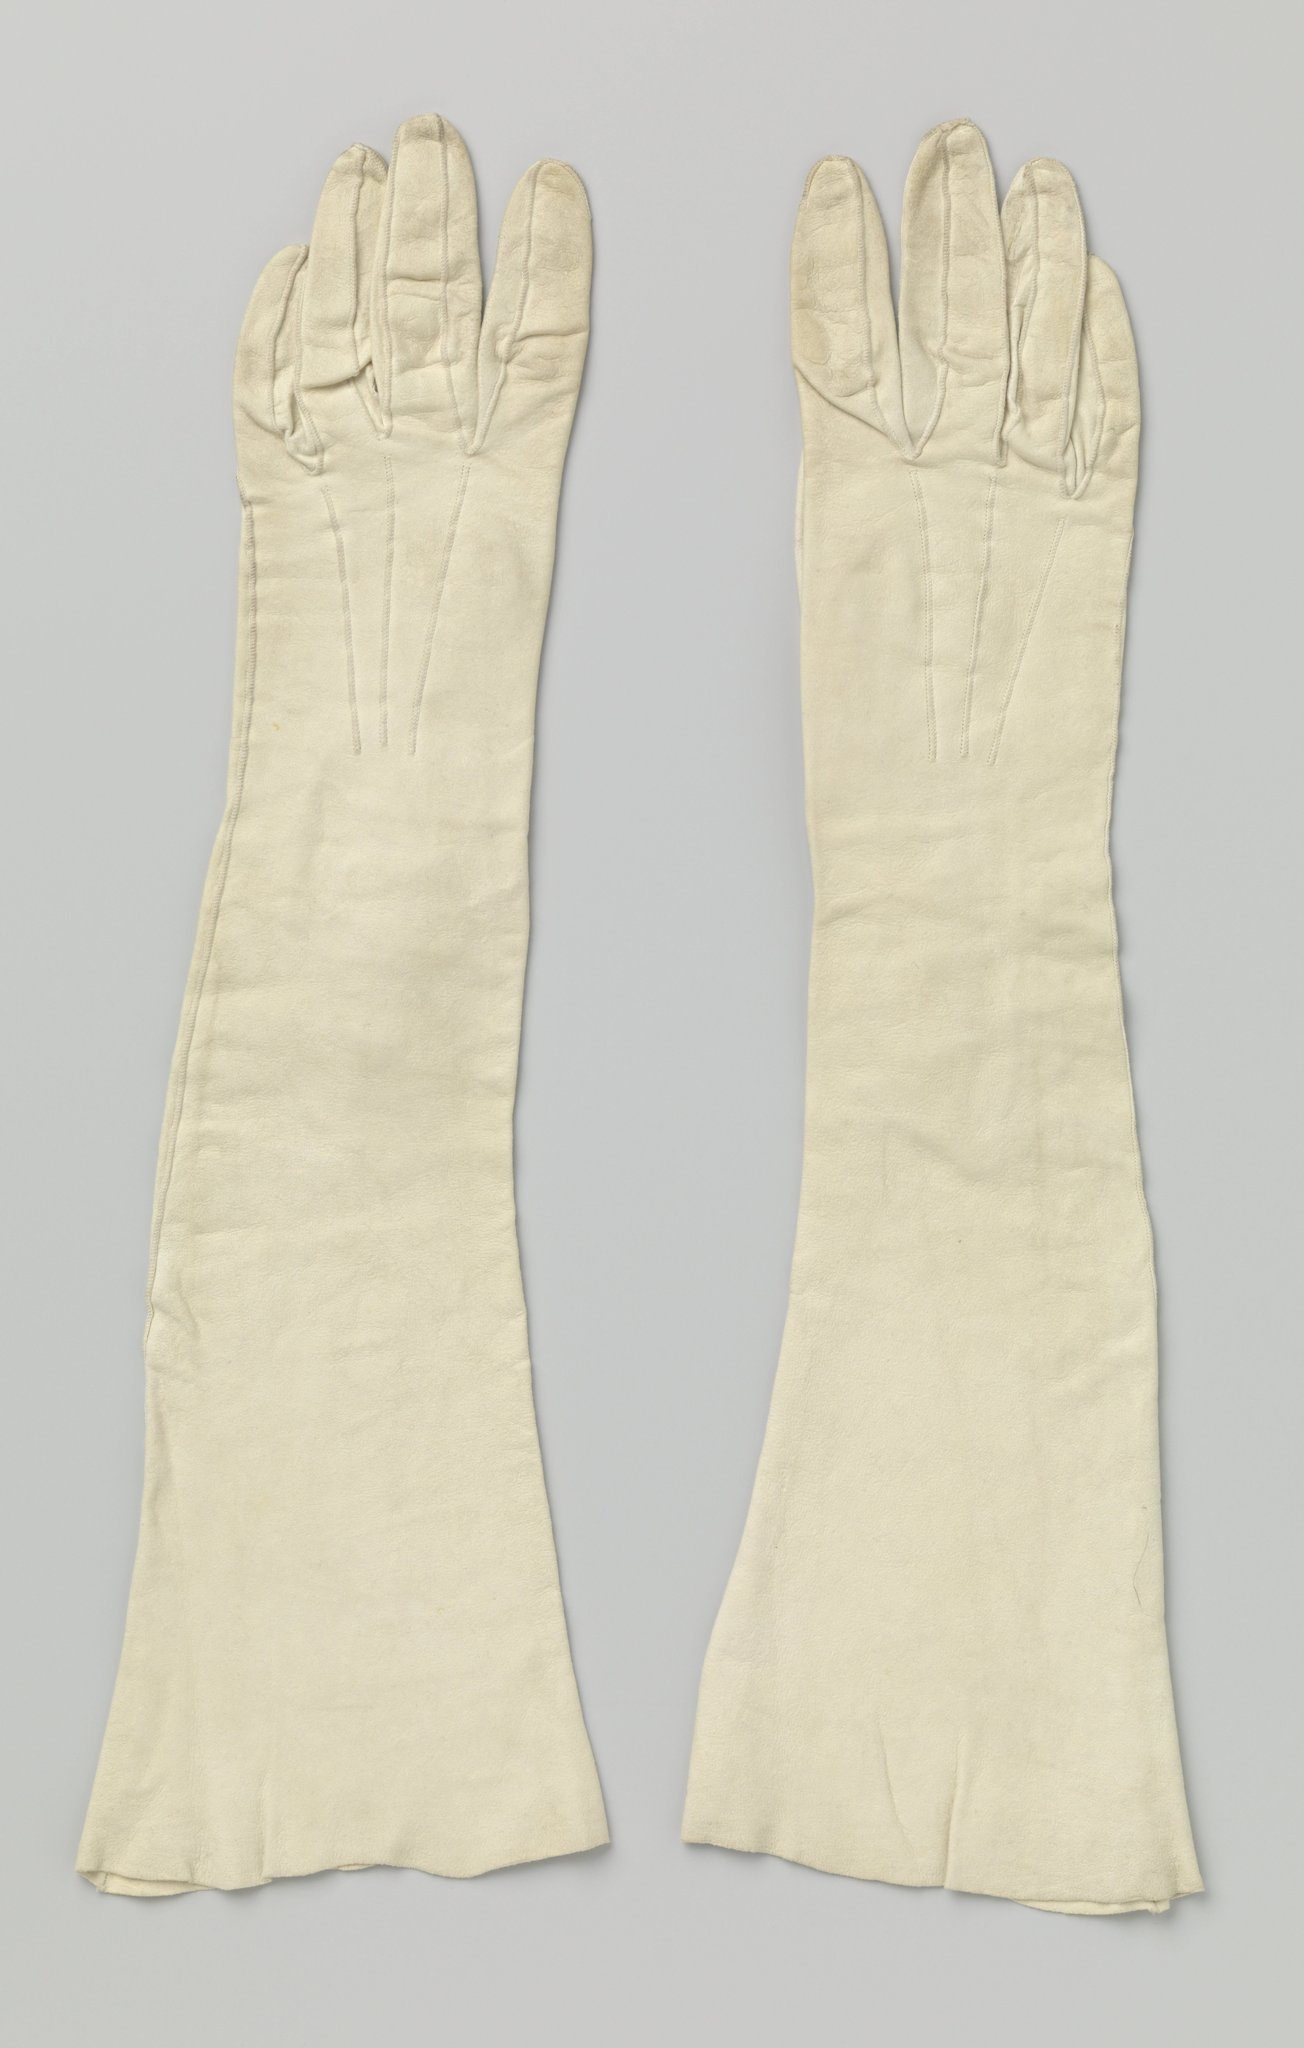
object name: clothing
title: Handschoen van wit zeemleer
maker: Anonymous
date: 1920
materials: leather, plastic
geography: france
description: Linkerhandschoen, van wit zeemleer met bij de pols een split met drie parelmoerkleurige knopen.